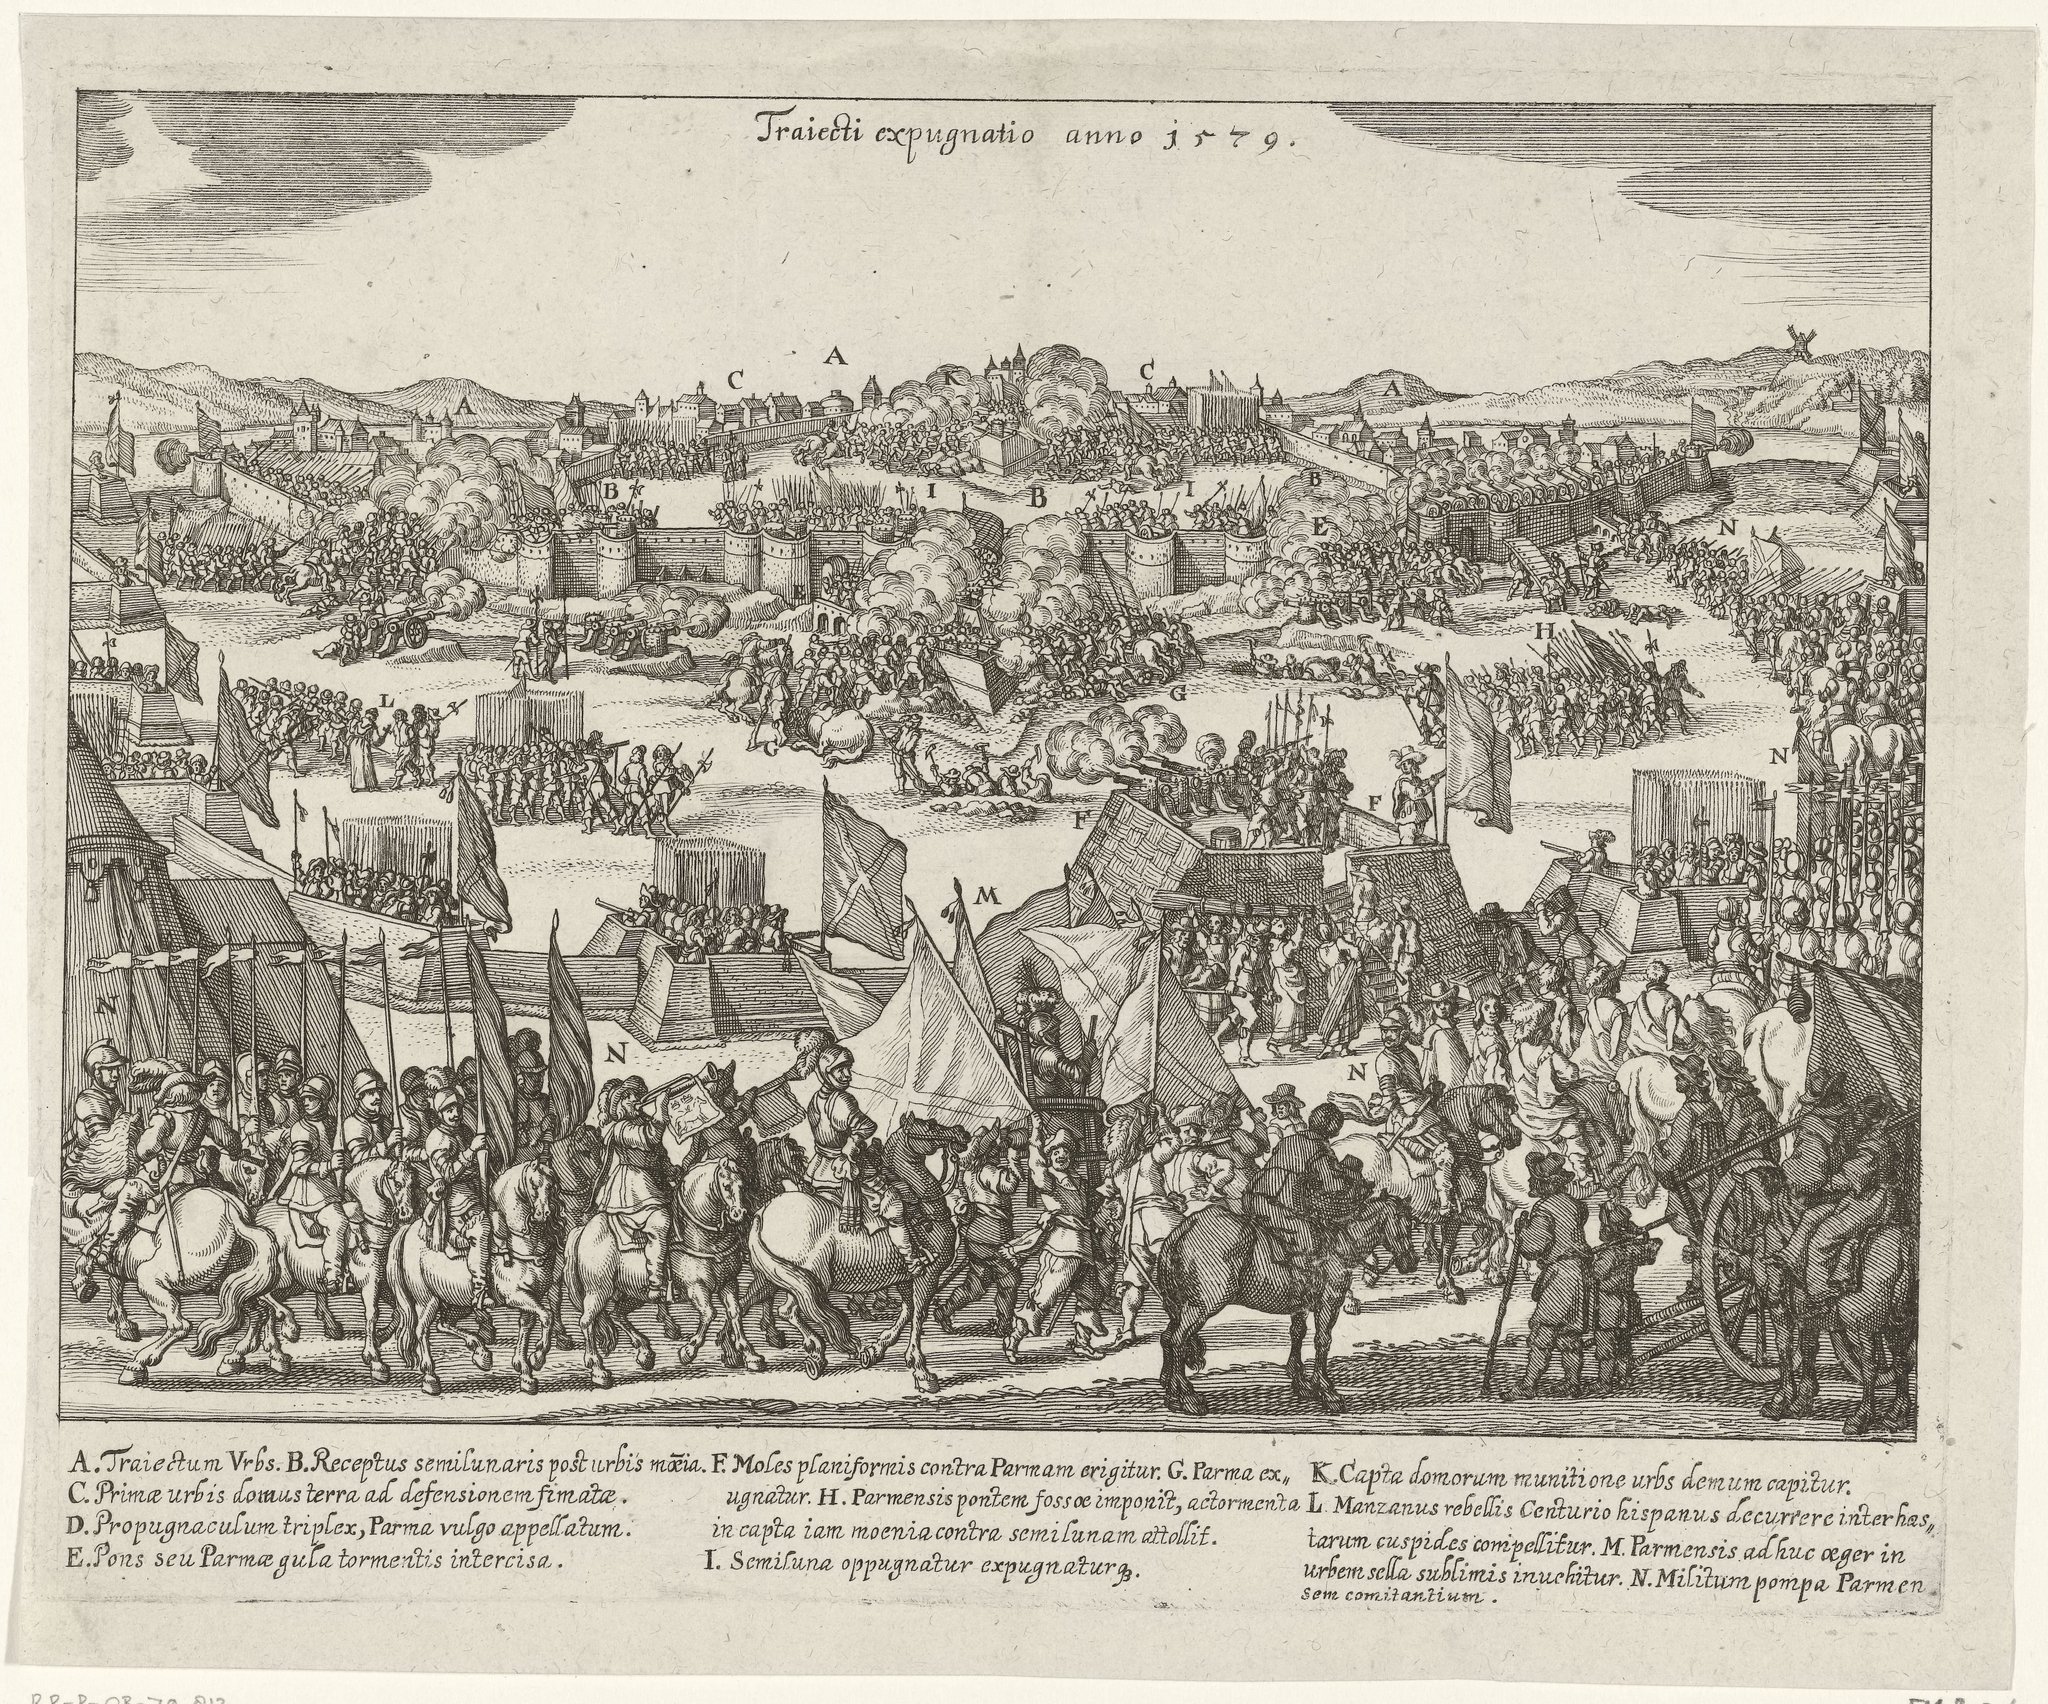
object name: history print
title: Maastricht veroverd door Parma, 1579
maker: Anonymous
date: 1649-1651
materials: paper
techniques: etching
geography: rome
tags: alessandro farnese (landvoogd van de nederlanden en hertog van parma en piacenza), (carrying a person in a) sedan-chair, capture of city (after the siege), maastricht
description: Maastricht na beleg veroverd door het leger van Parma, 29 juni 1579. Voor de stadsmuren wordt nog geschoten en gevochten. Op de voorgrond de stoet met de hertog van Parma in een draagstoel die naar rechts en de stad in trekt. In het onderschrift de legenda A-N in het Latijn.